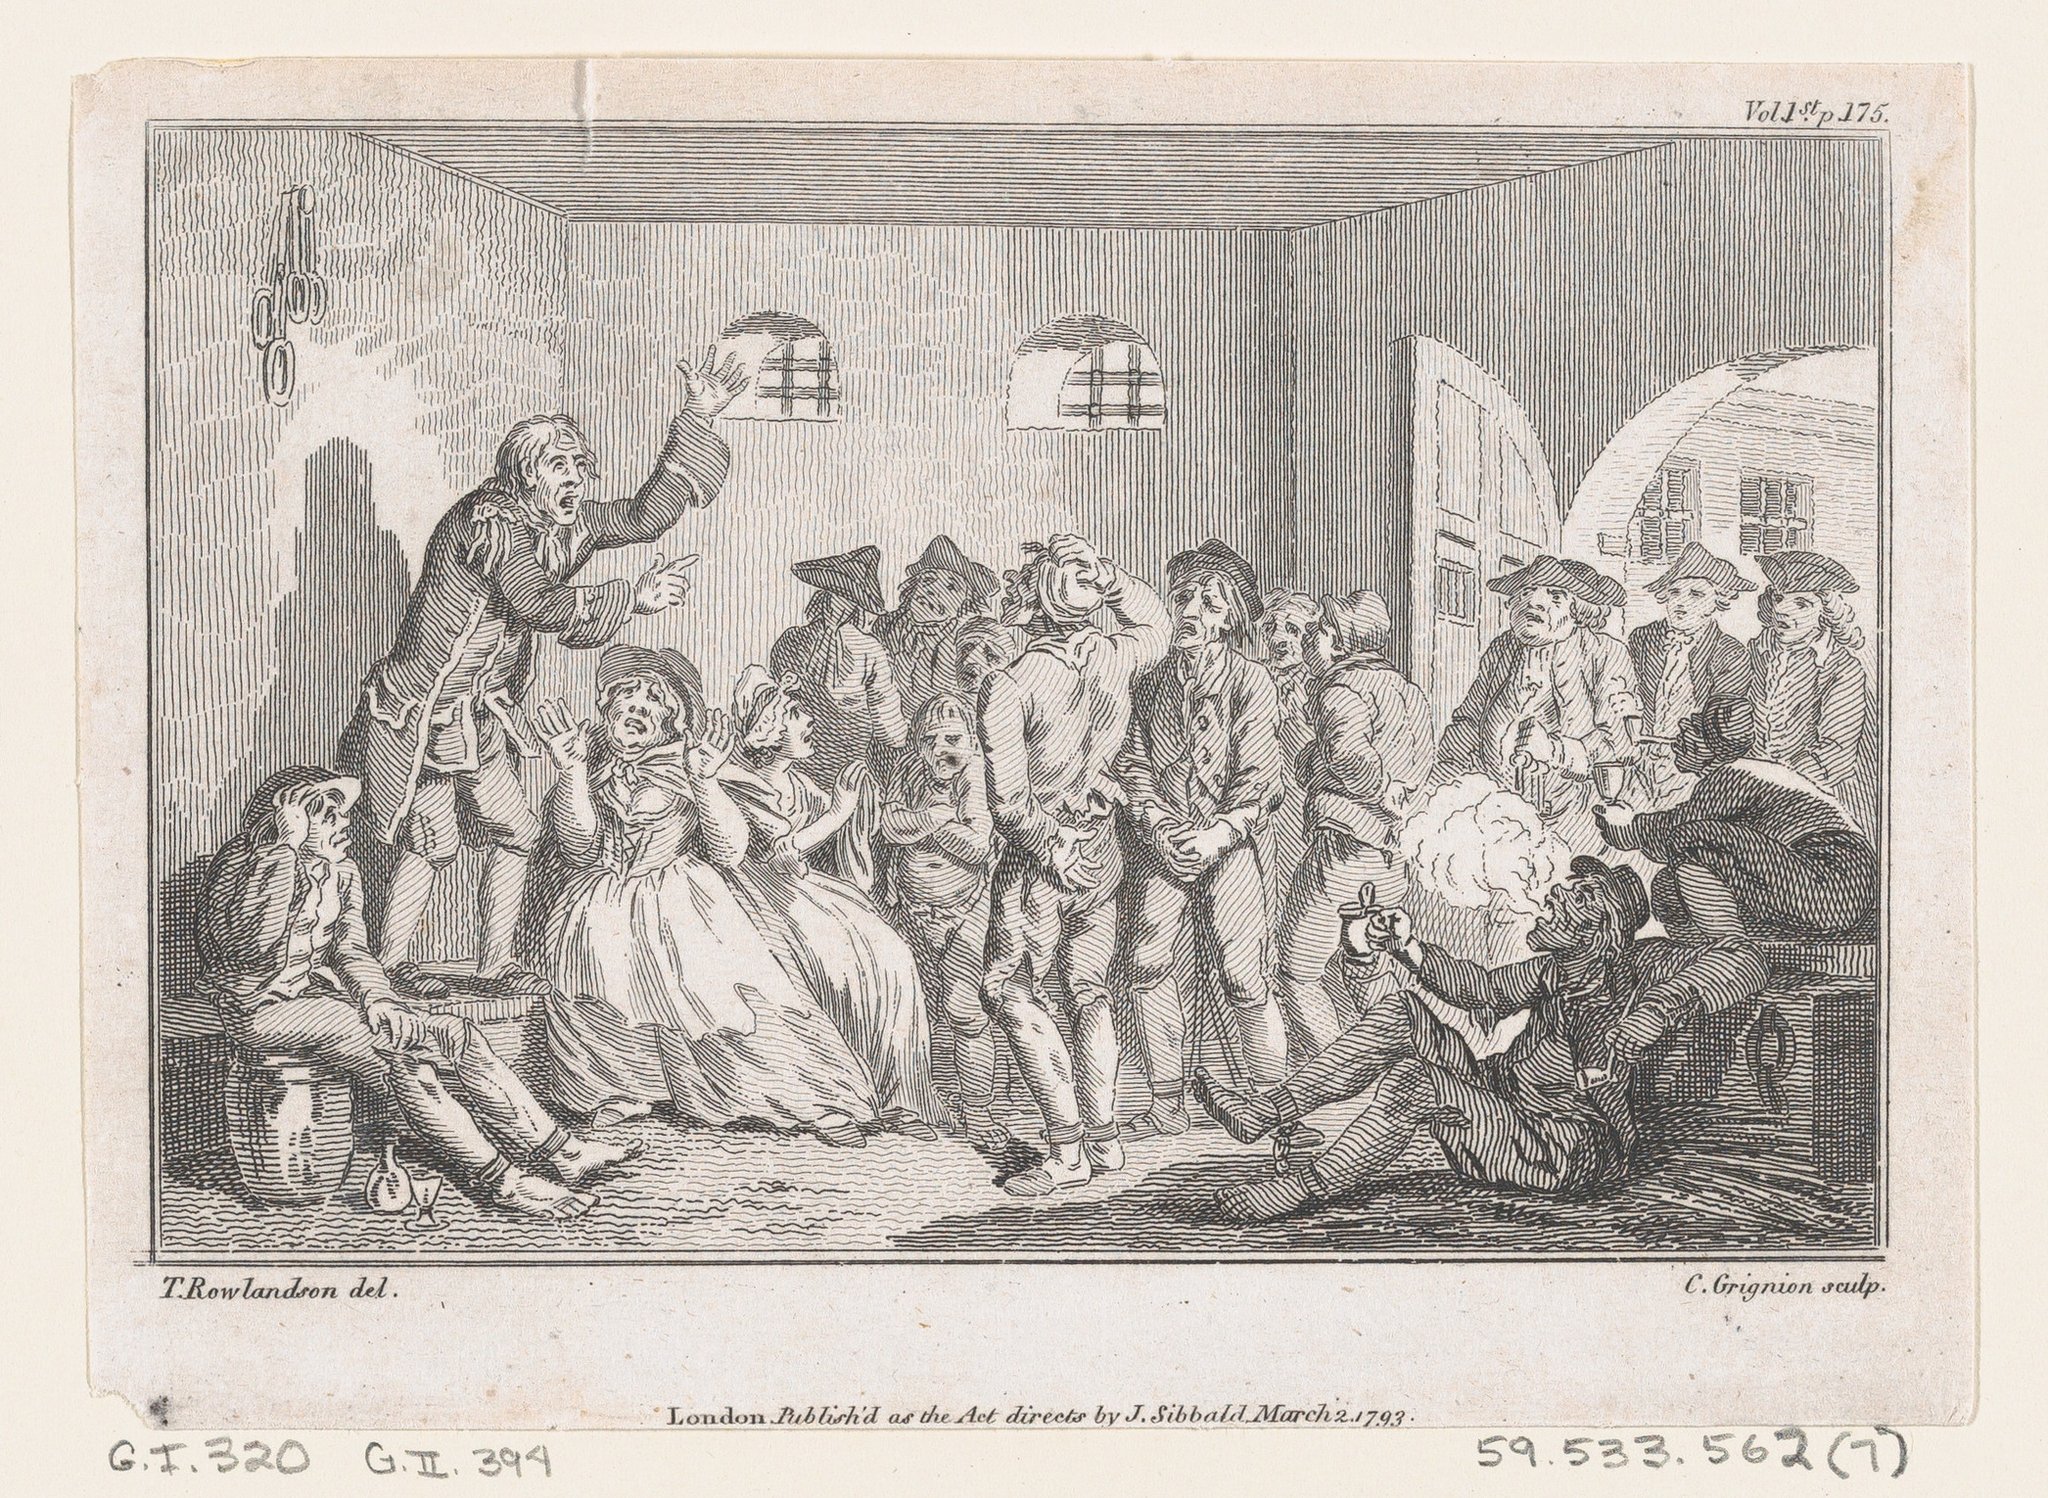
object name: print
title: Clinker Preaching in Clerkenwell Prison, an illustration from Tobias Smollett's "The Expedition of Humphry Clinker" (London, 1793), Vol. 1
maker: charles grignion, i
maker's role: artist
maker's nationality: british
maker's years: 1710-1810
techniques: engraving, etching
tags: prisons,men,women